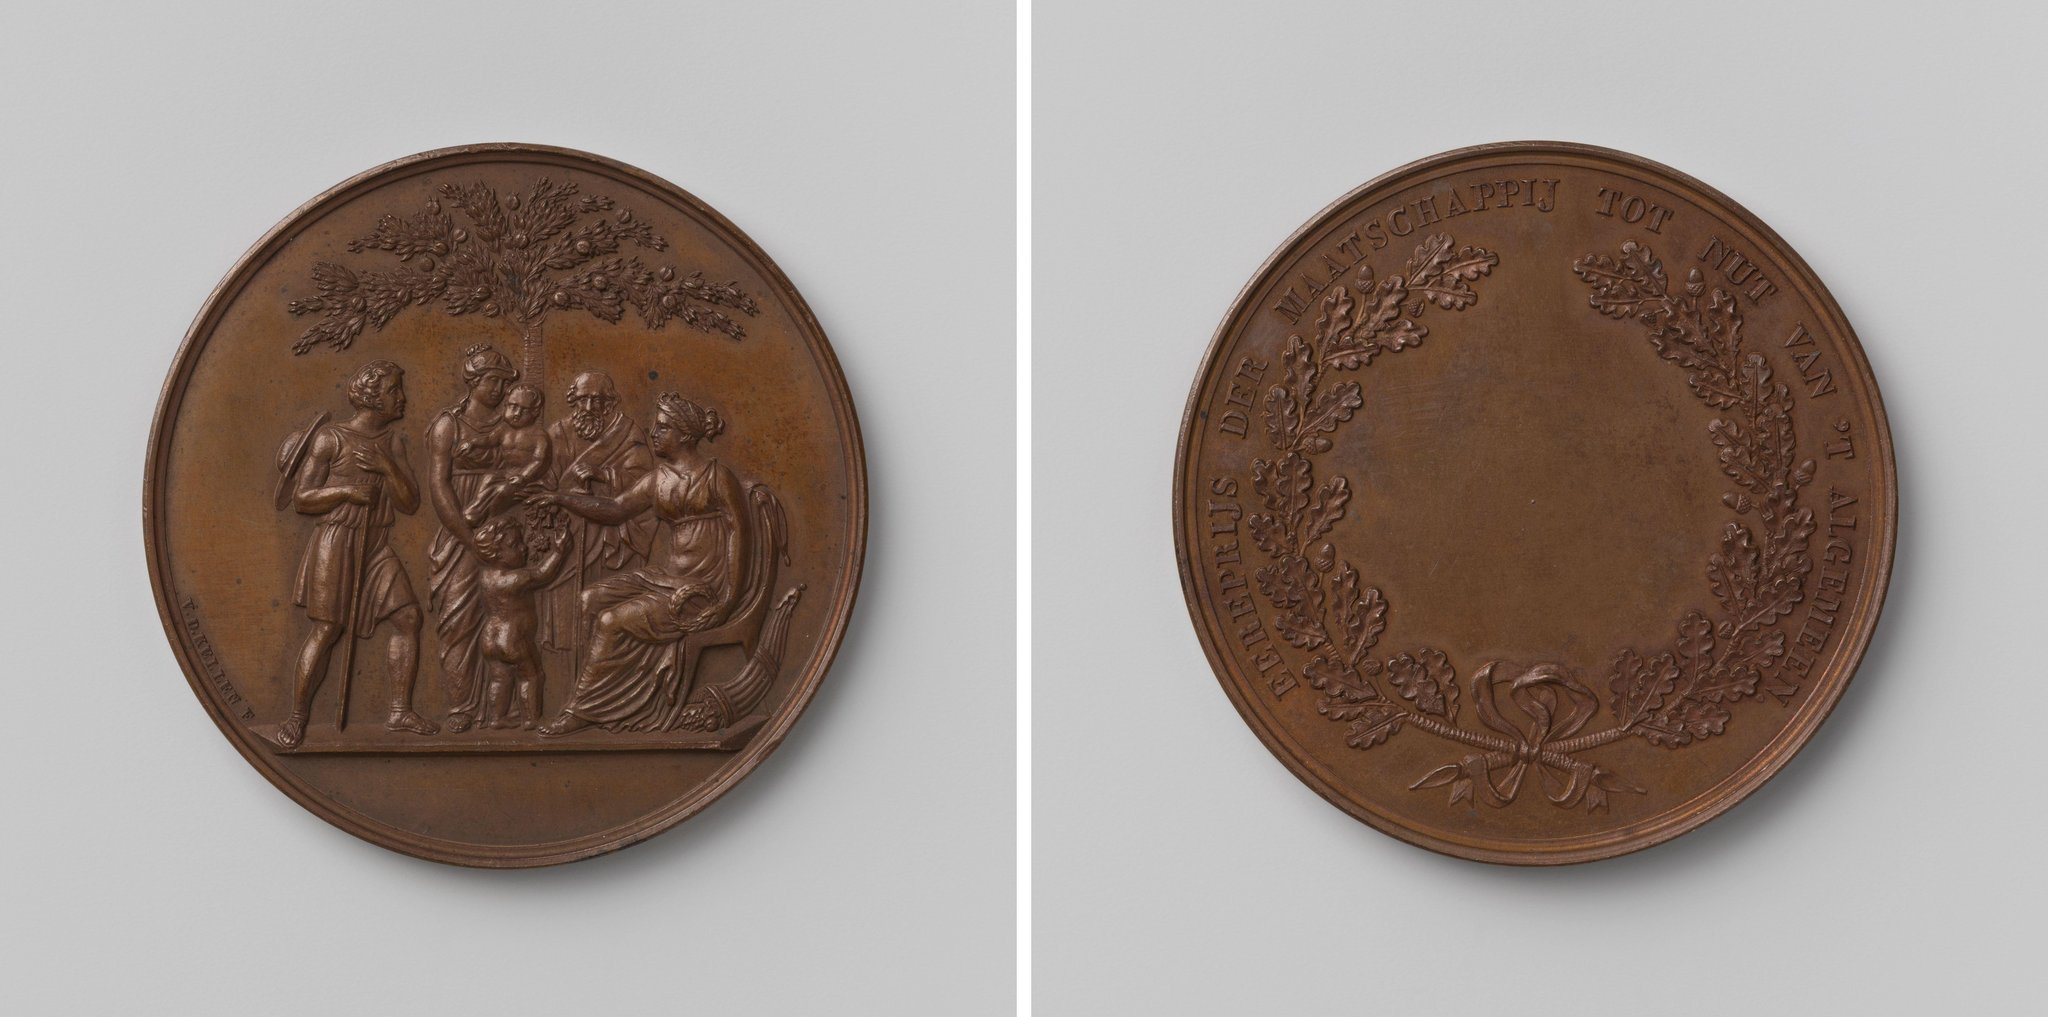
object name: medal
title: Maatschappij tot Nut van 't Algemeen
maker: david van der kellen (1804-1879)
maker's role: die cutter, draughtsman, print maker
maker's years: 1804-1879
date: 1839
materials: bronze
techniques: striking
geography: utrecht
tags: maatschappij tot nut van 't algemeen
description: Bronzen penning. Voorzijde: Maatschappij, afgebeeld als jonge vrouw, zit onder vruchtdragende oranjeboom en houdt in haar linkerhand lauwerkrans, terwijl zij met andere hand bloemen strooit temidden van rond haar verzameld groepje mensen; achter stoel: gevulde hoorn van overvloed. Keerzijde: blanco veld binnen eikekrans en omschrift